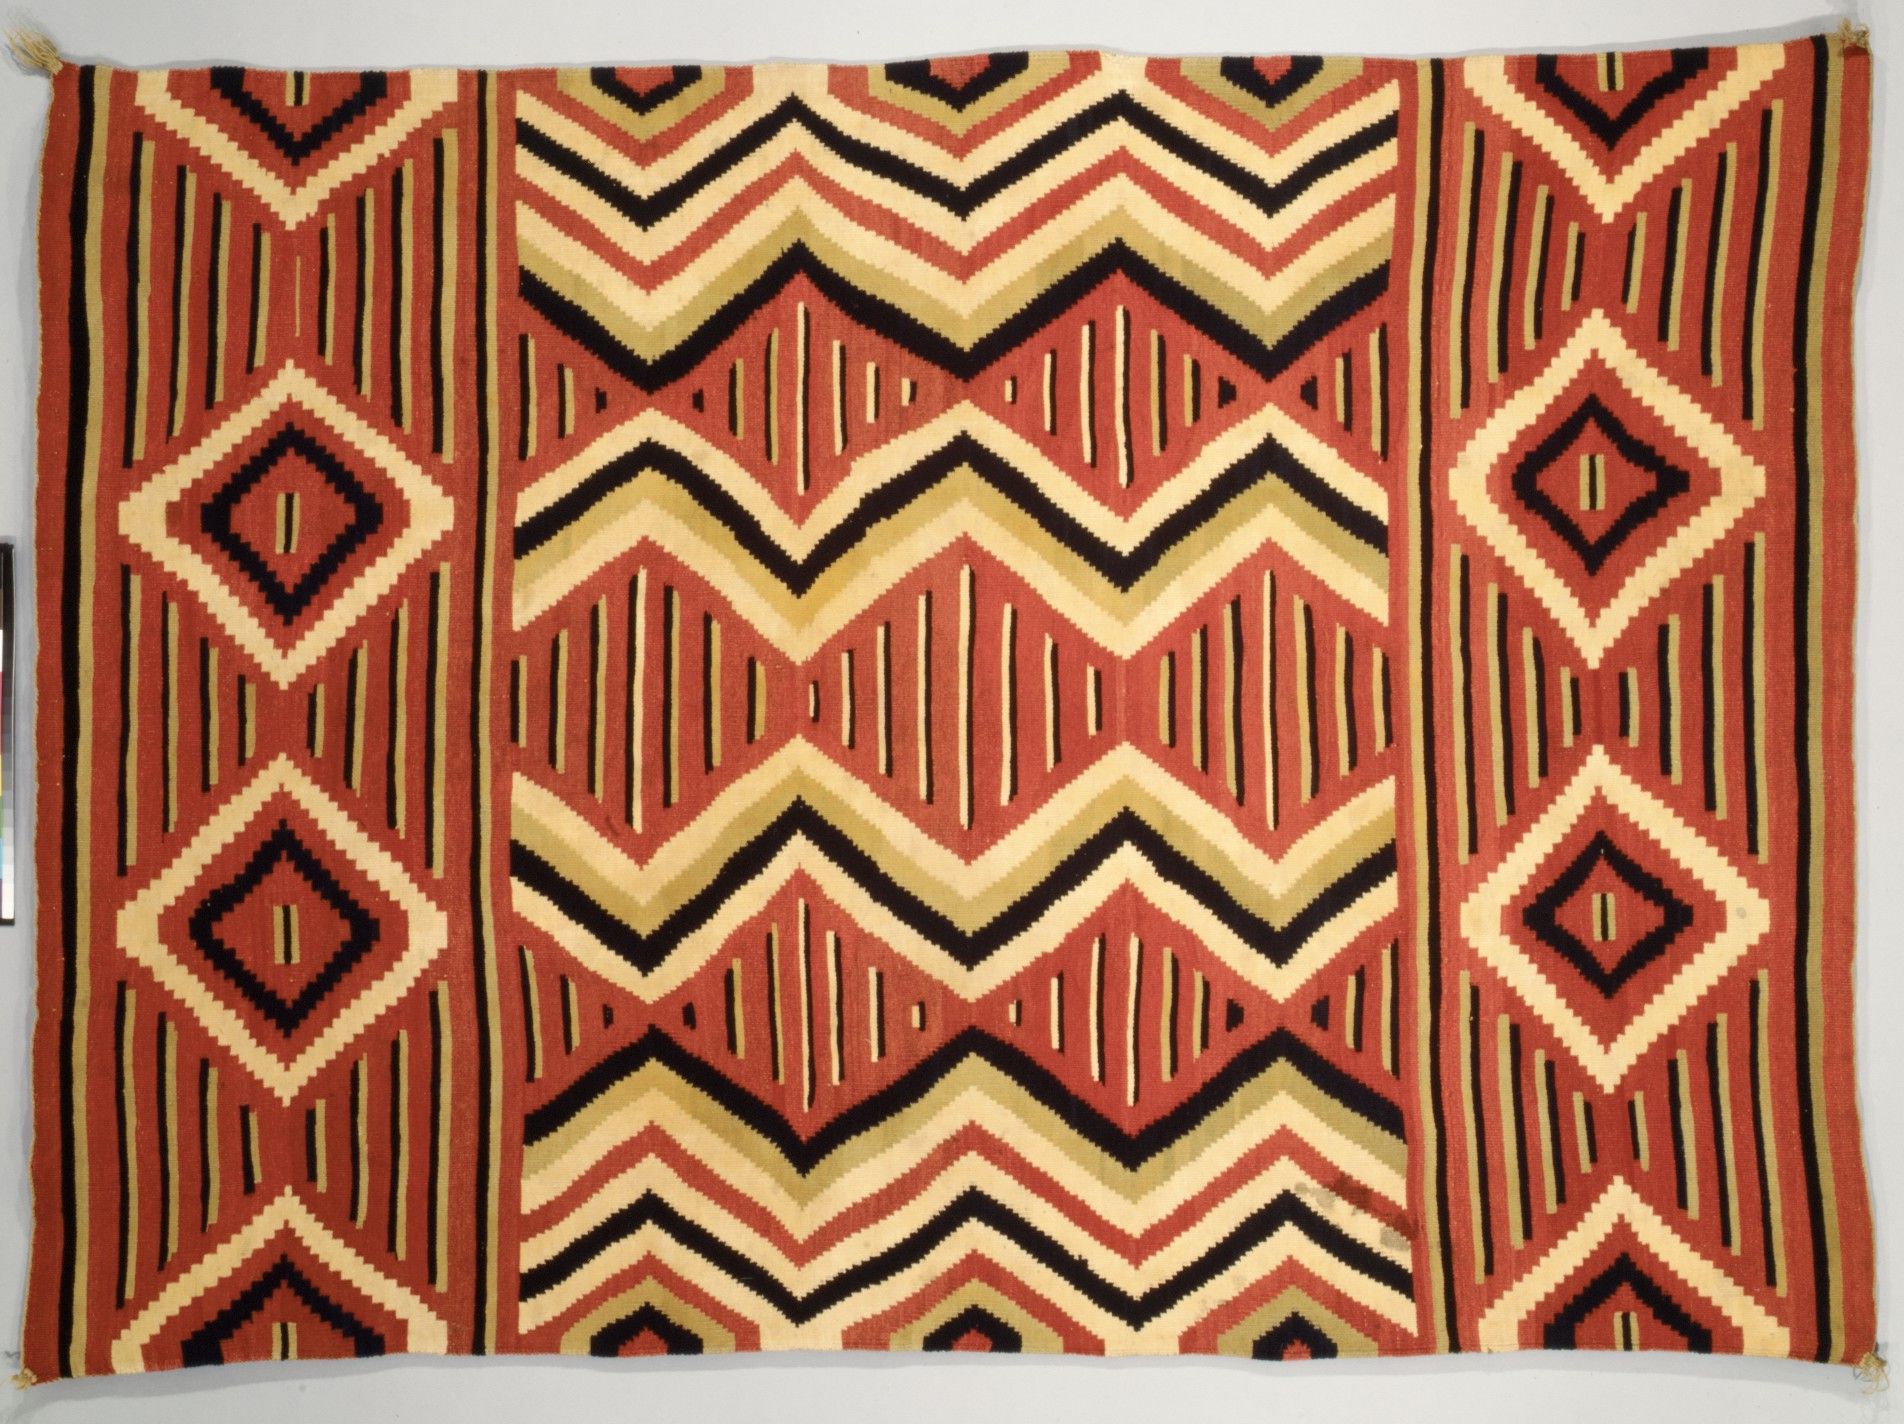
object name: blanket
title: Wearing Blanket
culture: navajo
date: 1860-1870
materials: wool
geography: united states